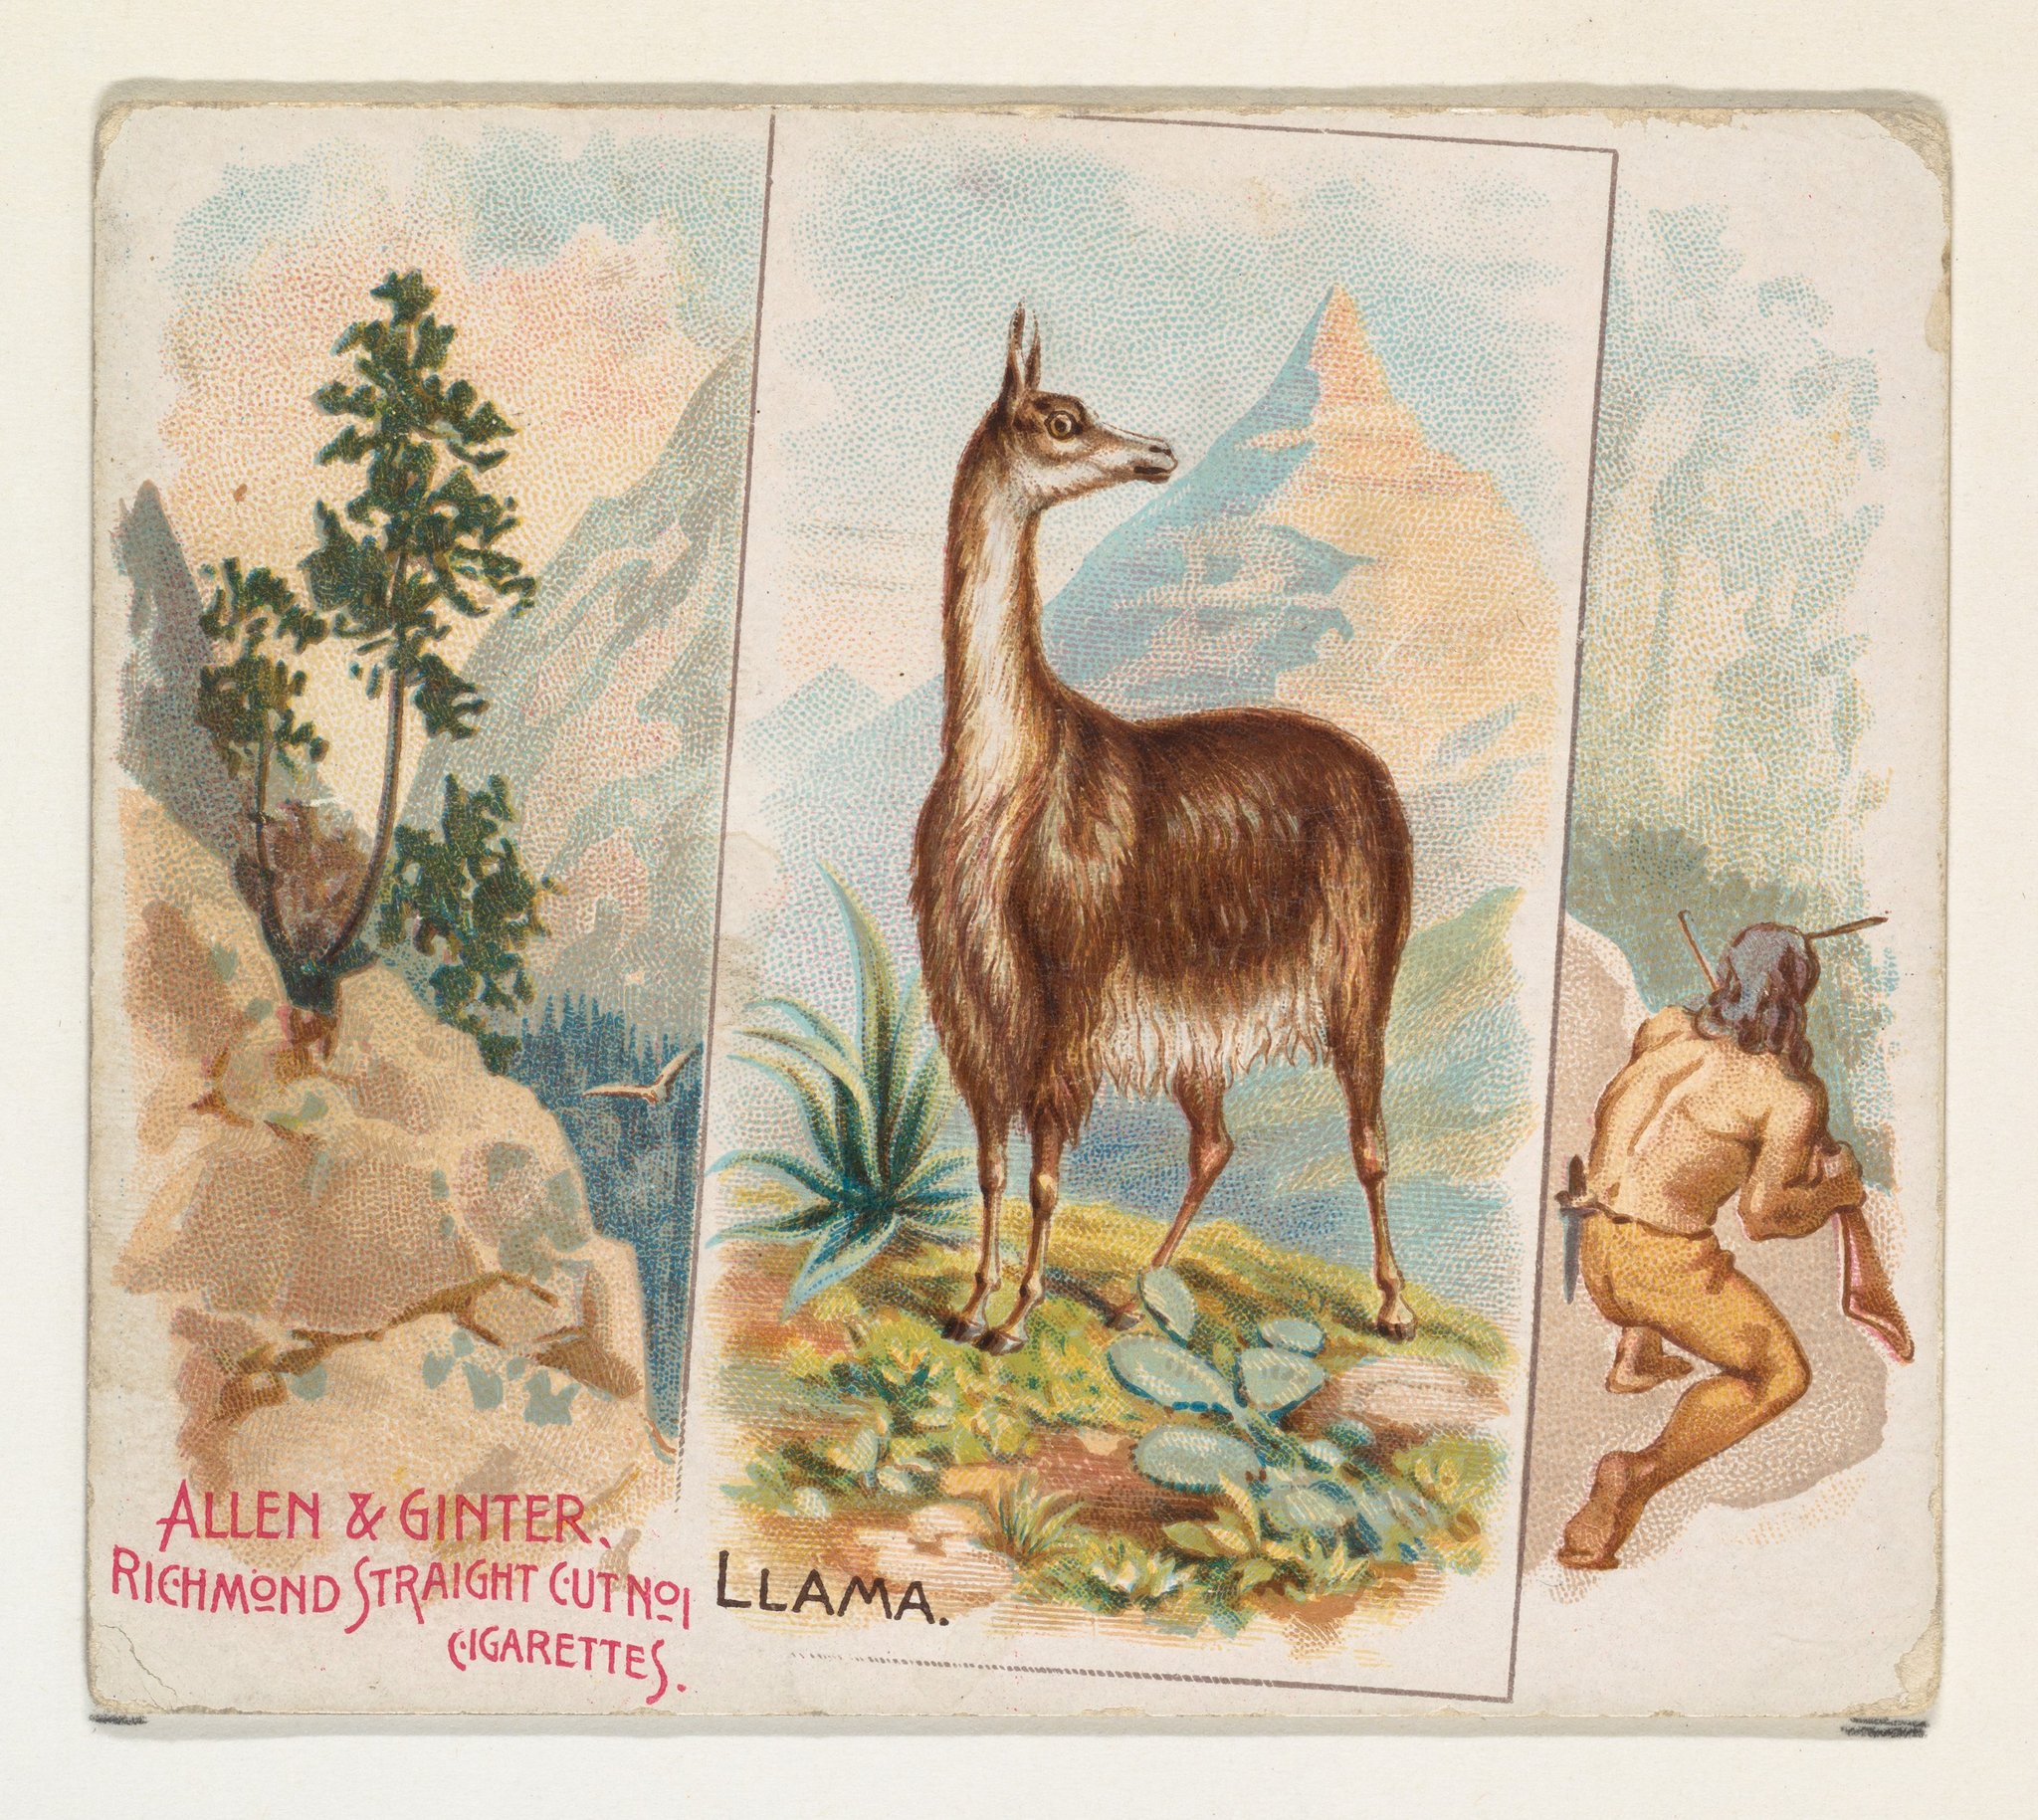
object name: print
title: Llama, from Quadrupeds series (N41) for Allen & Ginter Cigarettes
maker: allen & ginter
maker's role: publisher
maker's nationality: american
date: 1890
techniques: color lithograph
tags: animals